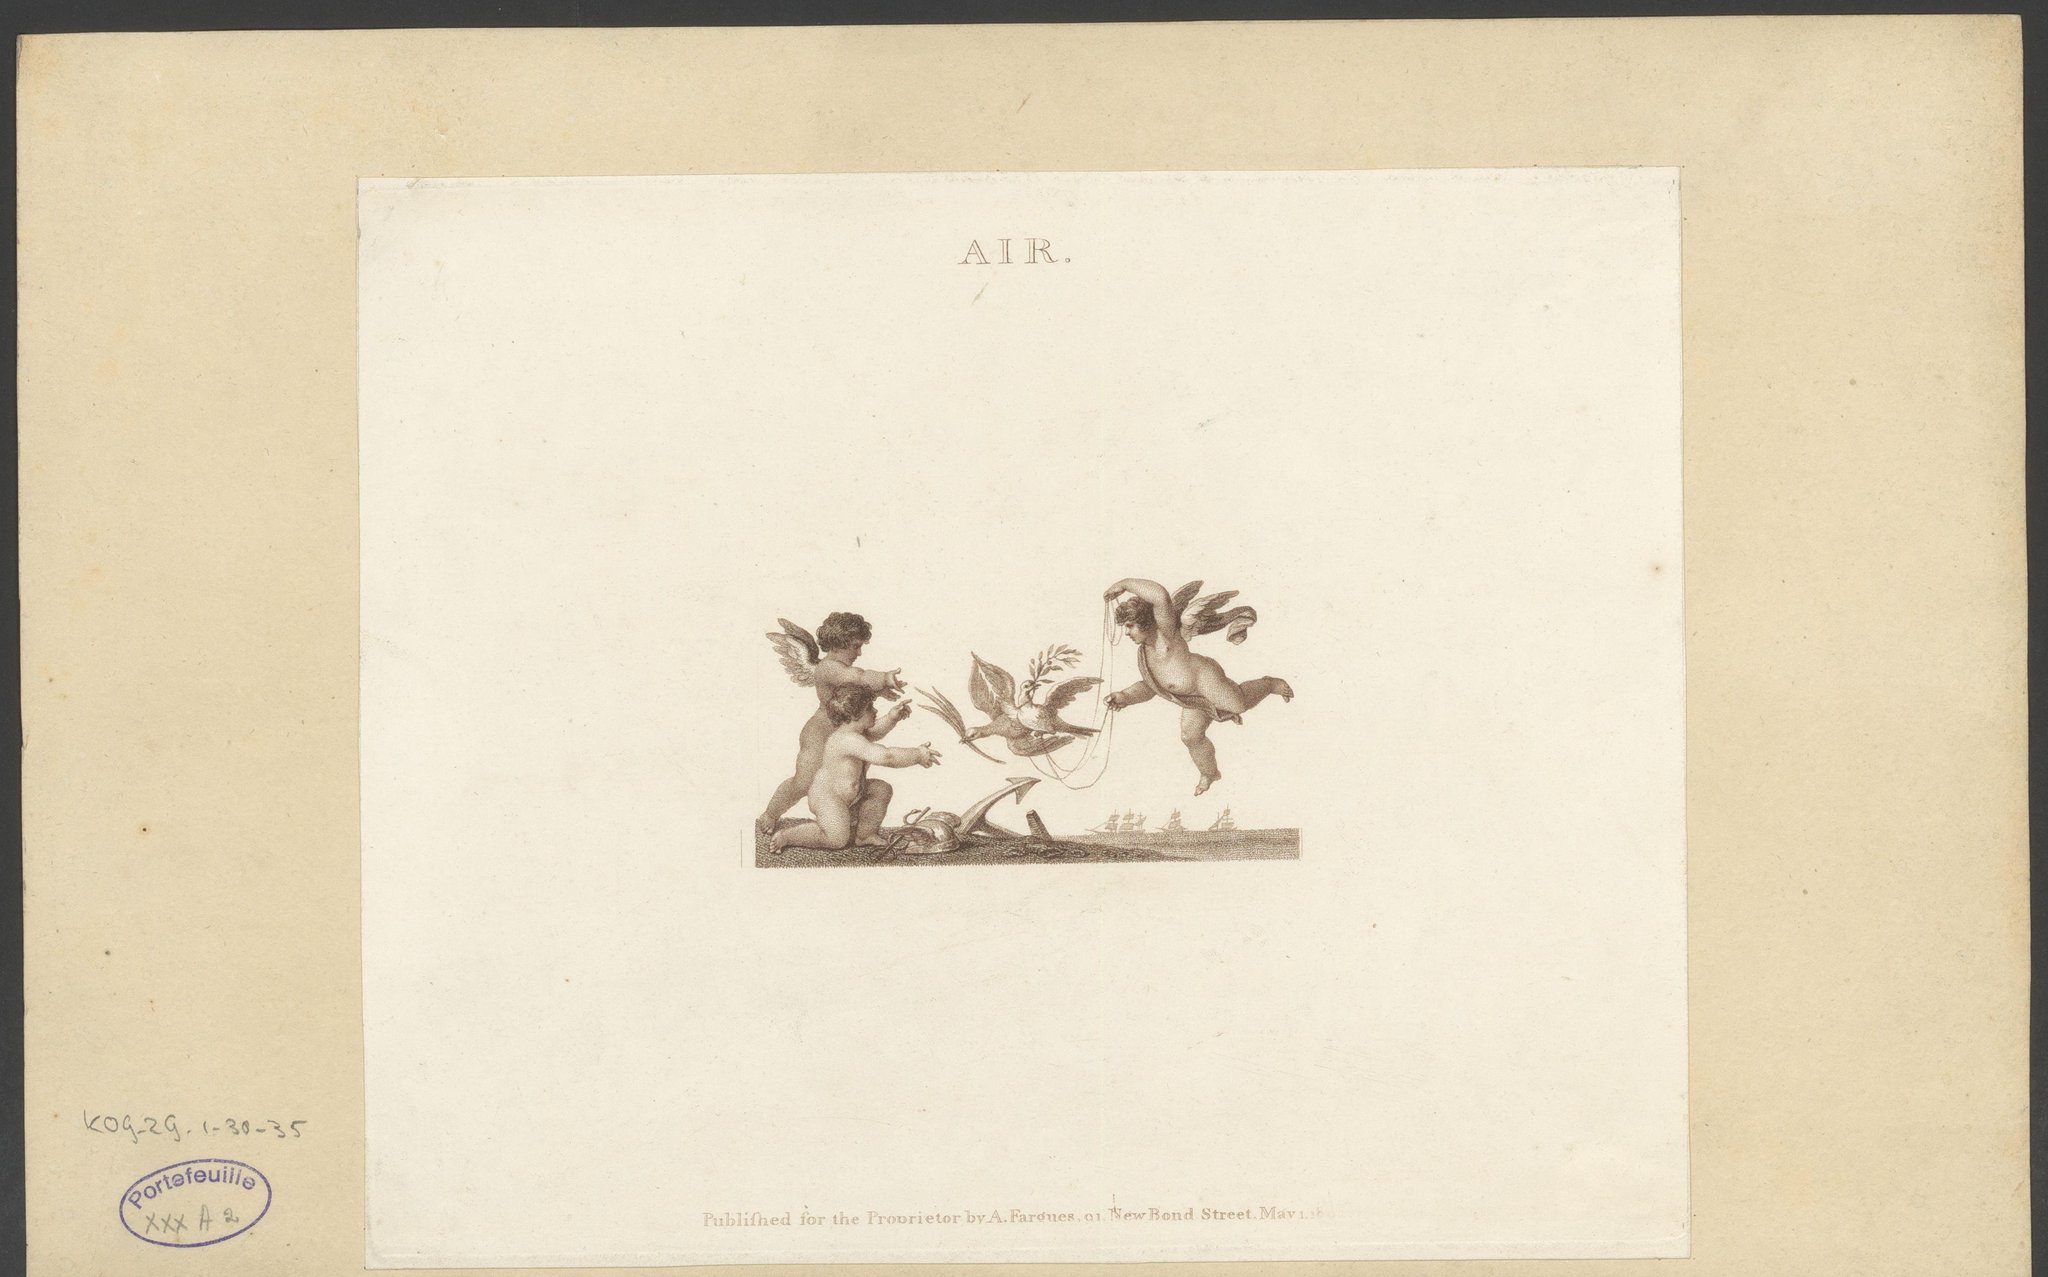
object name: print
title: Drie putti beelden het element lucht uit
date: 1802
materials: paper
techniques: etching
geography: amsterdam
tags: other birds: dove, air (one of the four elements), cupids: 'amores', 'amoretti', 'putti'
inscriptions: stamp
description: Drie putti beelden het element lucht uit met twee duiven en een olijftak. Onderwerpsrubrieken binnen de Atlas Zeden en Gewoonten: Zeden en Gewoonten in engeren zin. Volksleven. Zinnebeeldige voorstellingen uit het volkleven op serieprenten. Elementen.